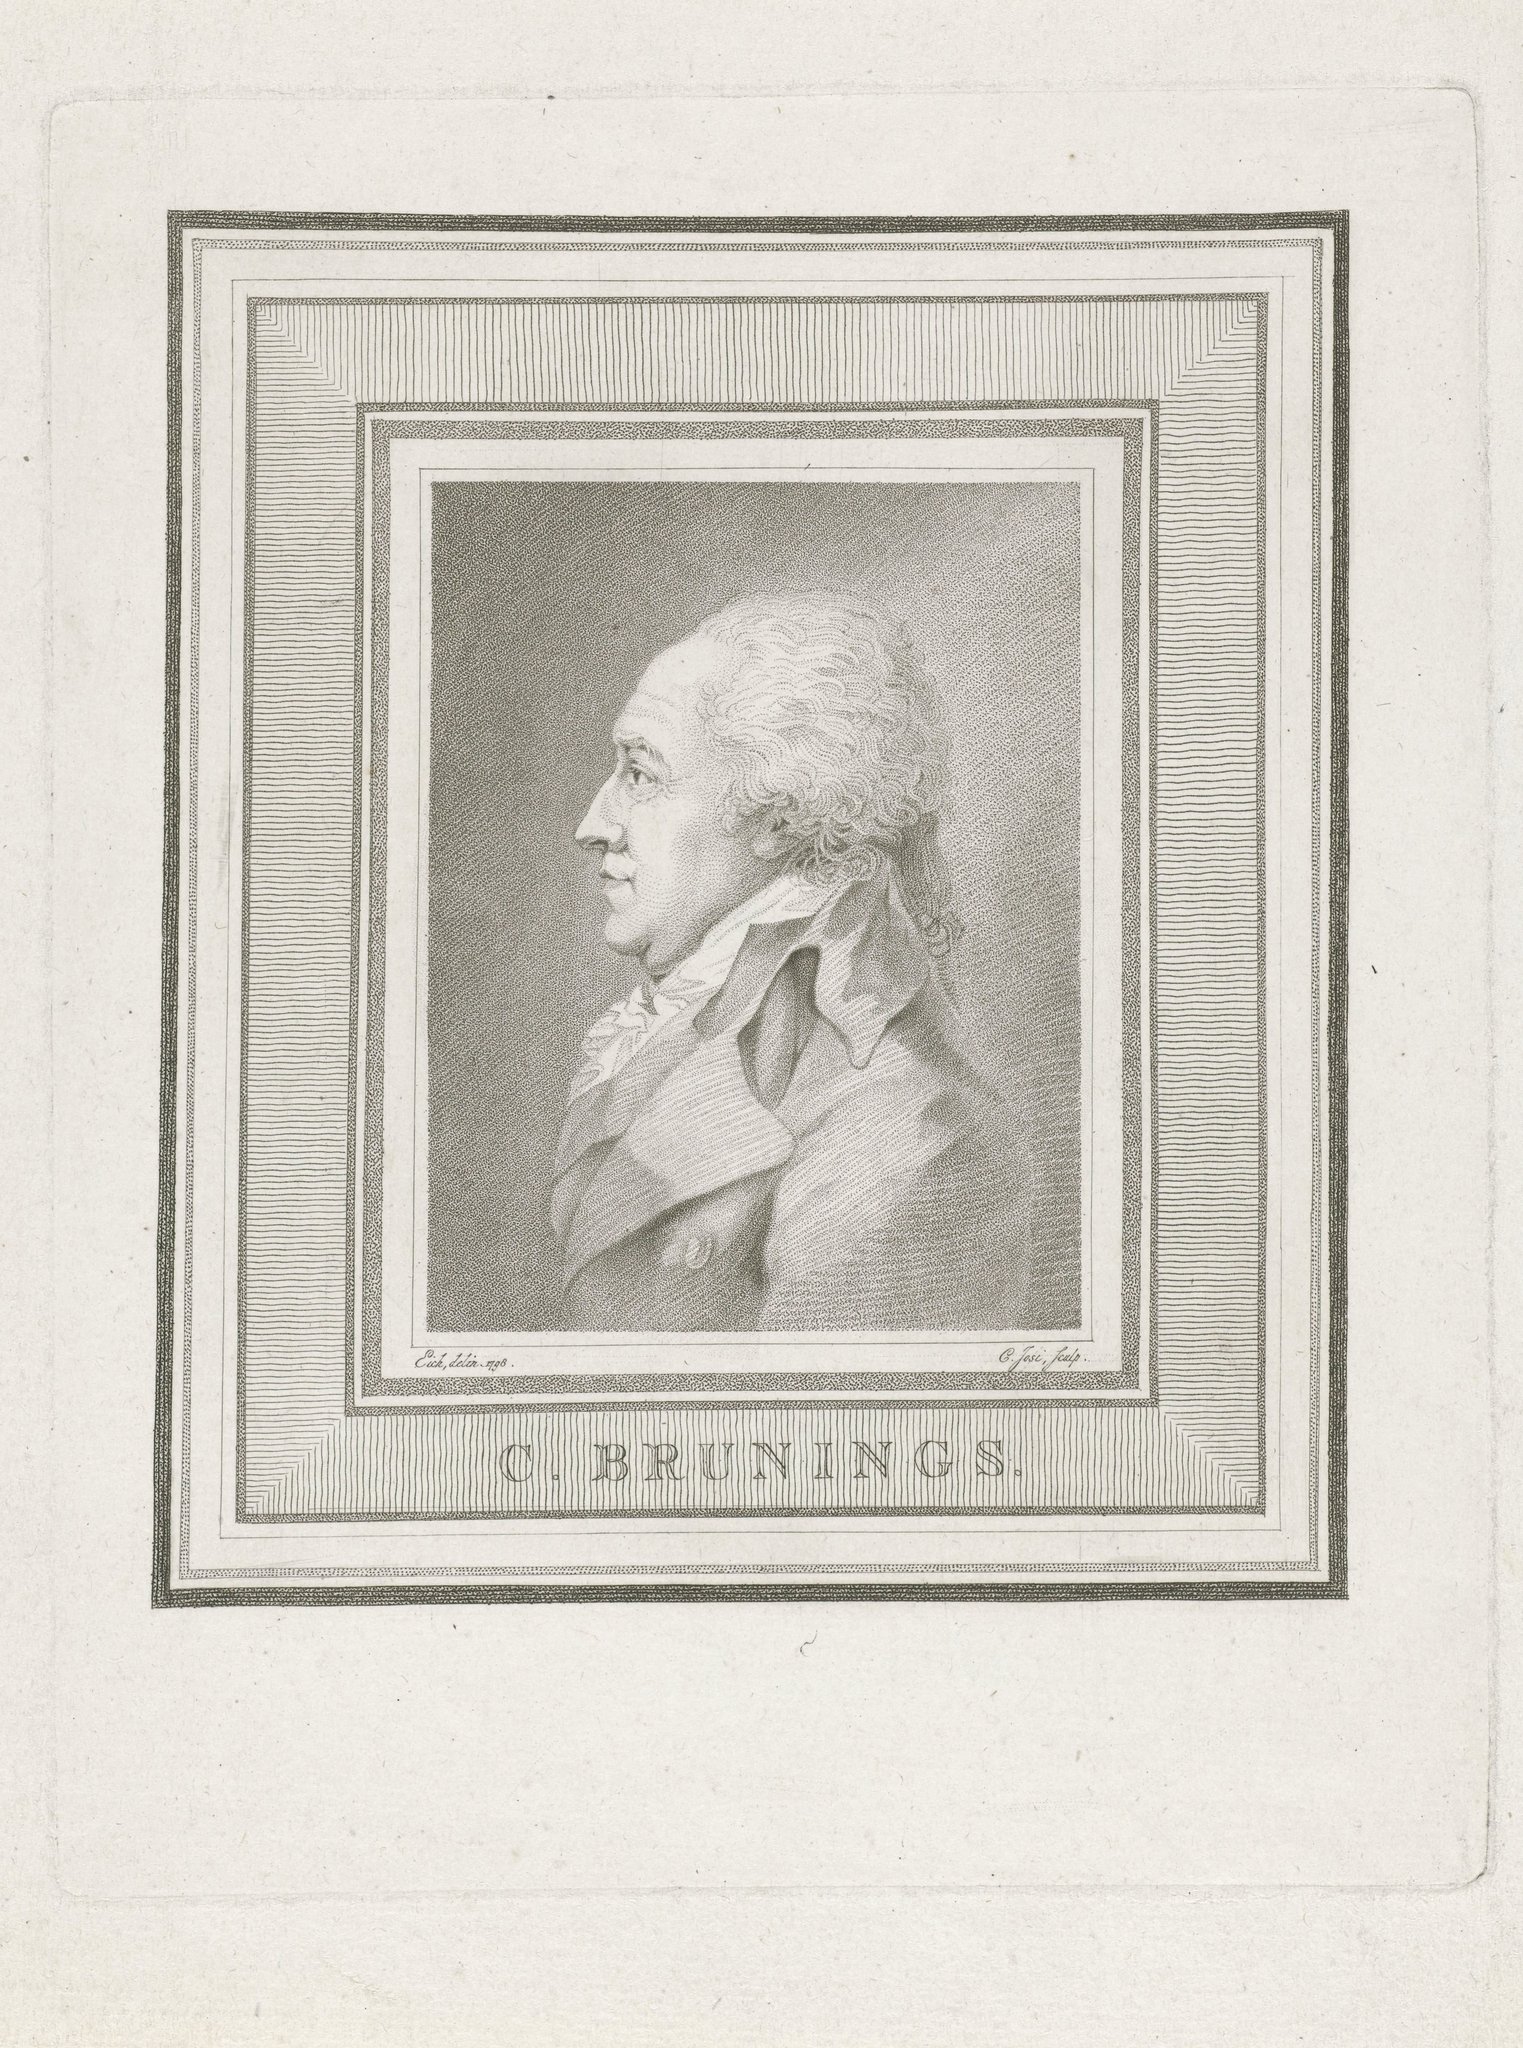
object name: print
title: Portret van Christiaan Brunings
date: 1798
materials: paper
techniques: stippled etching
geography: amsterdam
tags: christiaan l. brunings (i)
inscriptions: collector's mark: Lugt 2228, collector's mark: Lugt 2760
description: Busteportret van de waterbouwkundige Christiaan Brunings. Het portret is gevat in een rechthoekige omlijsting met de naam van de geportretteerde.